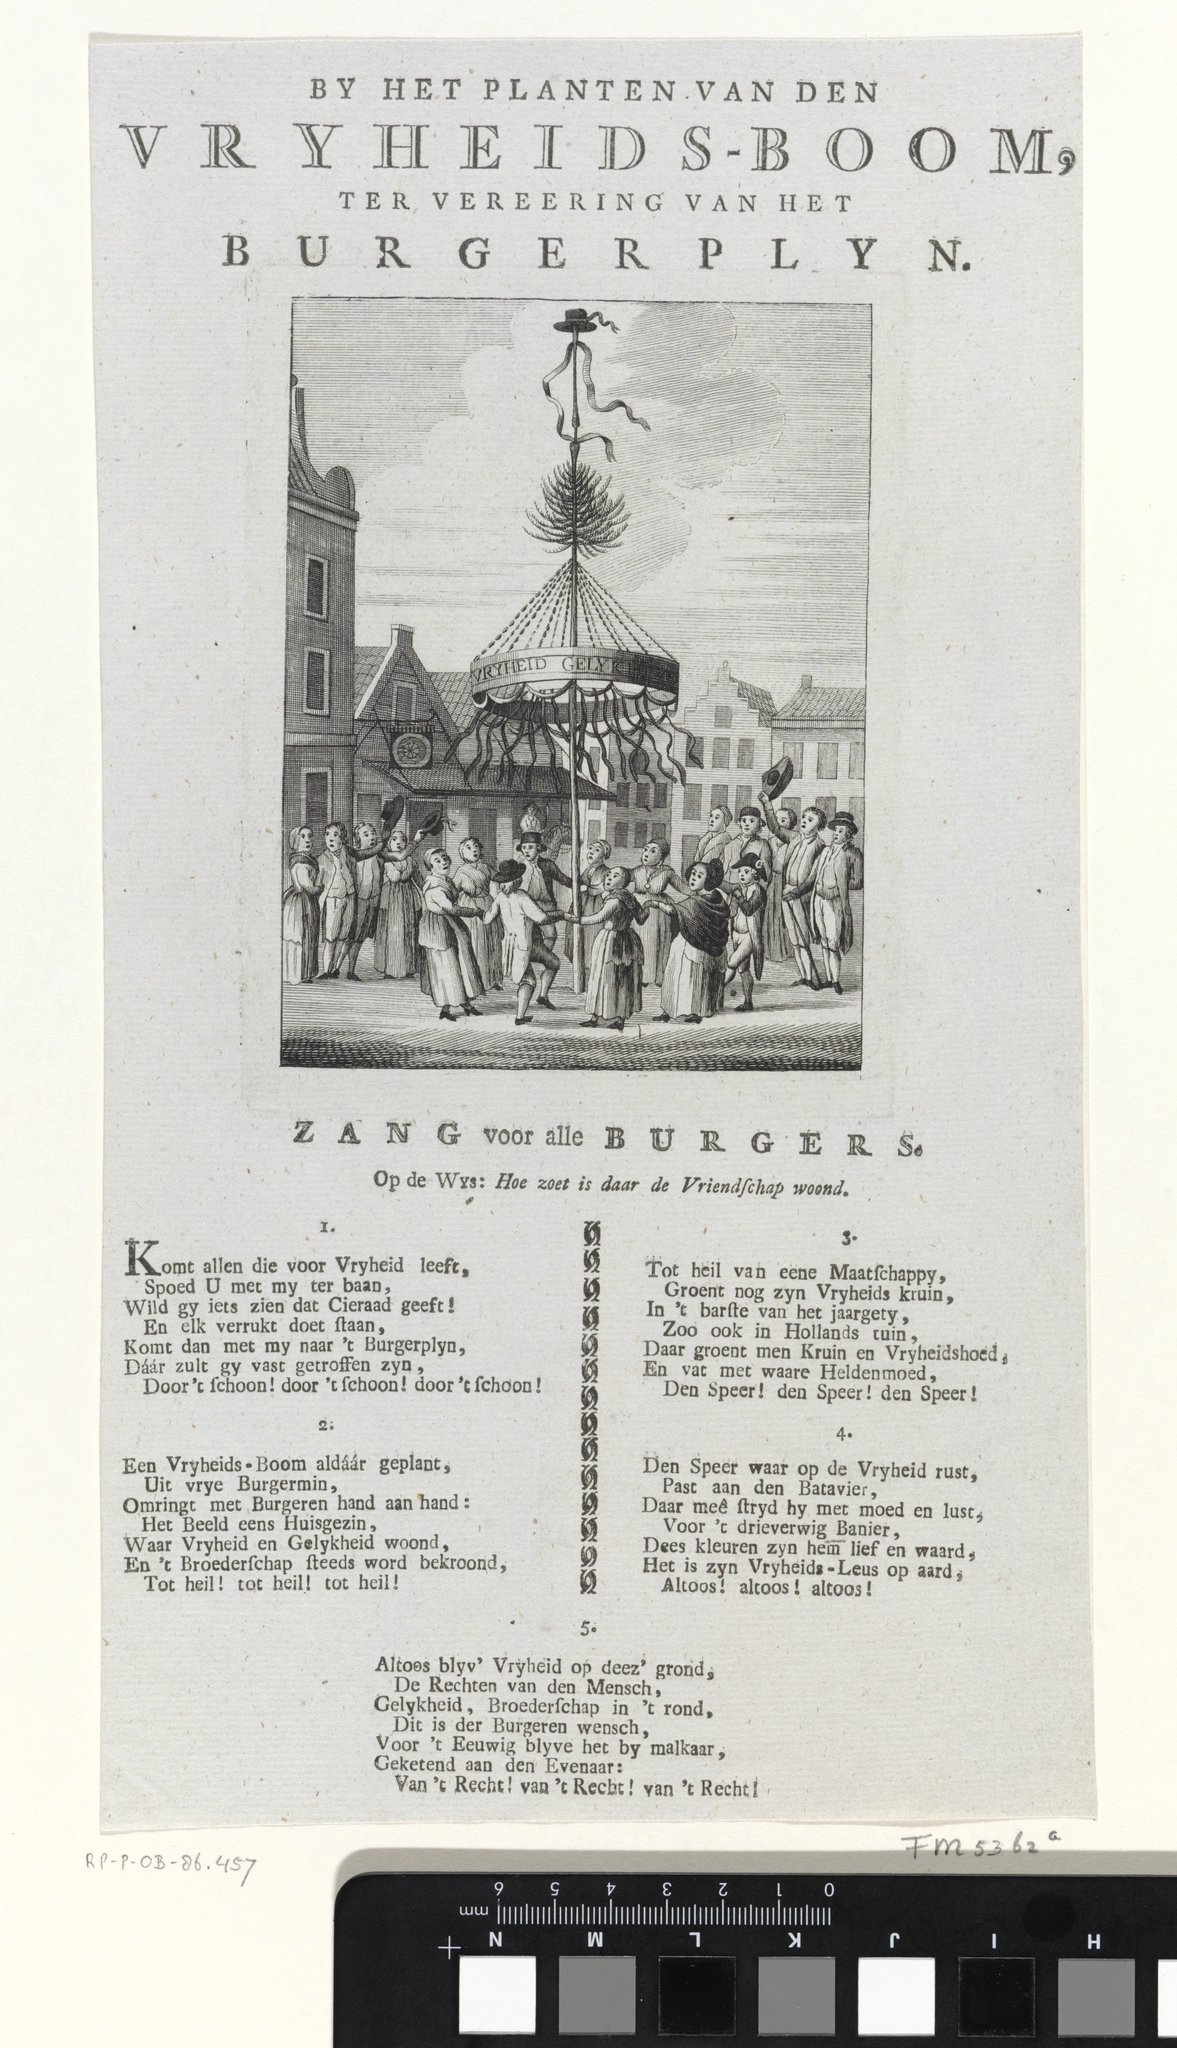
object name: song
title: By het planten van den Vryheids-boom, ter vereering van het Burgerplyn. Zang voor alle Burgers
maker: Anonymous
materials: paper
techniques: etching, letterpress printing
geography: netherlands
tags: dancing around the tree of liberty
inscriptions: collector's mark: Lugt 2228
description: Dansen om de Vrijheidsboom, opgericht 5-6 februari 1795 op het Koningsplein, destijds omgedoopt tot Burgerplein, te Amsterdam. Op het blad onder de plaat de tekst van een lied in vijf coupletten.